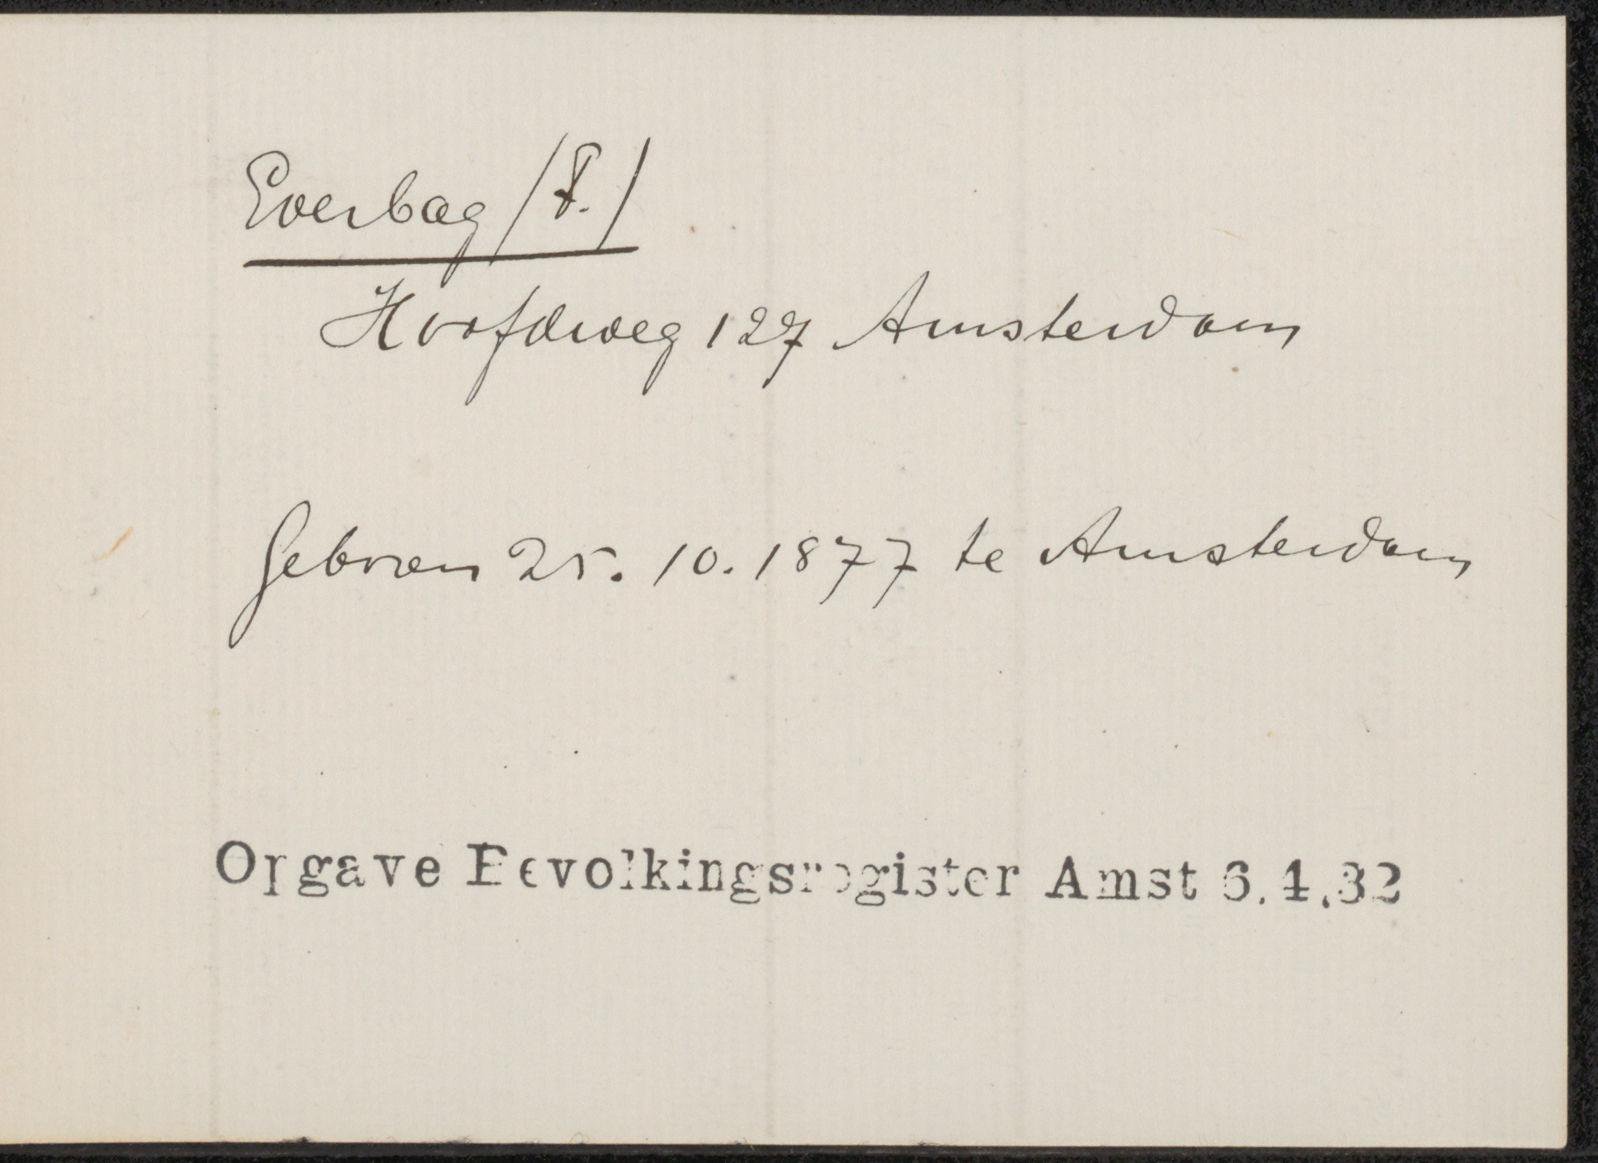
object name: document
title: Document betreffende Frans Everbag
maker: Anonymous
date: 1932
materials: ink, paper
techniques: pen, writing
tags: amsterdam, print maker, draughtsman, frans everbag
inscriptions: stamp: ‘Opgave Bevolkingsregister Amst 6.4.32’